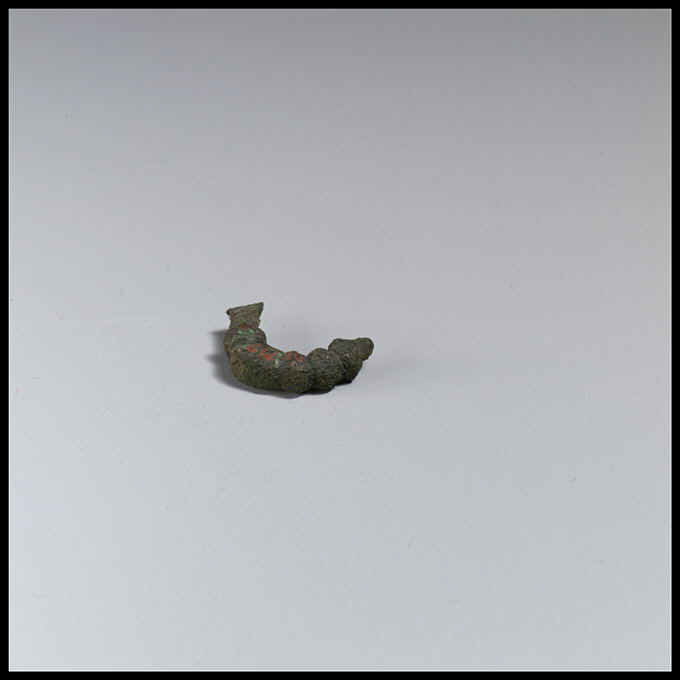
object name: fibula, fragment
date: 7000 BCE-330 CE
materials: bronze